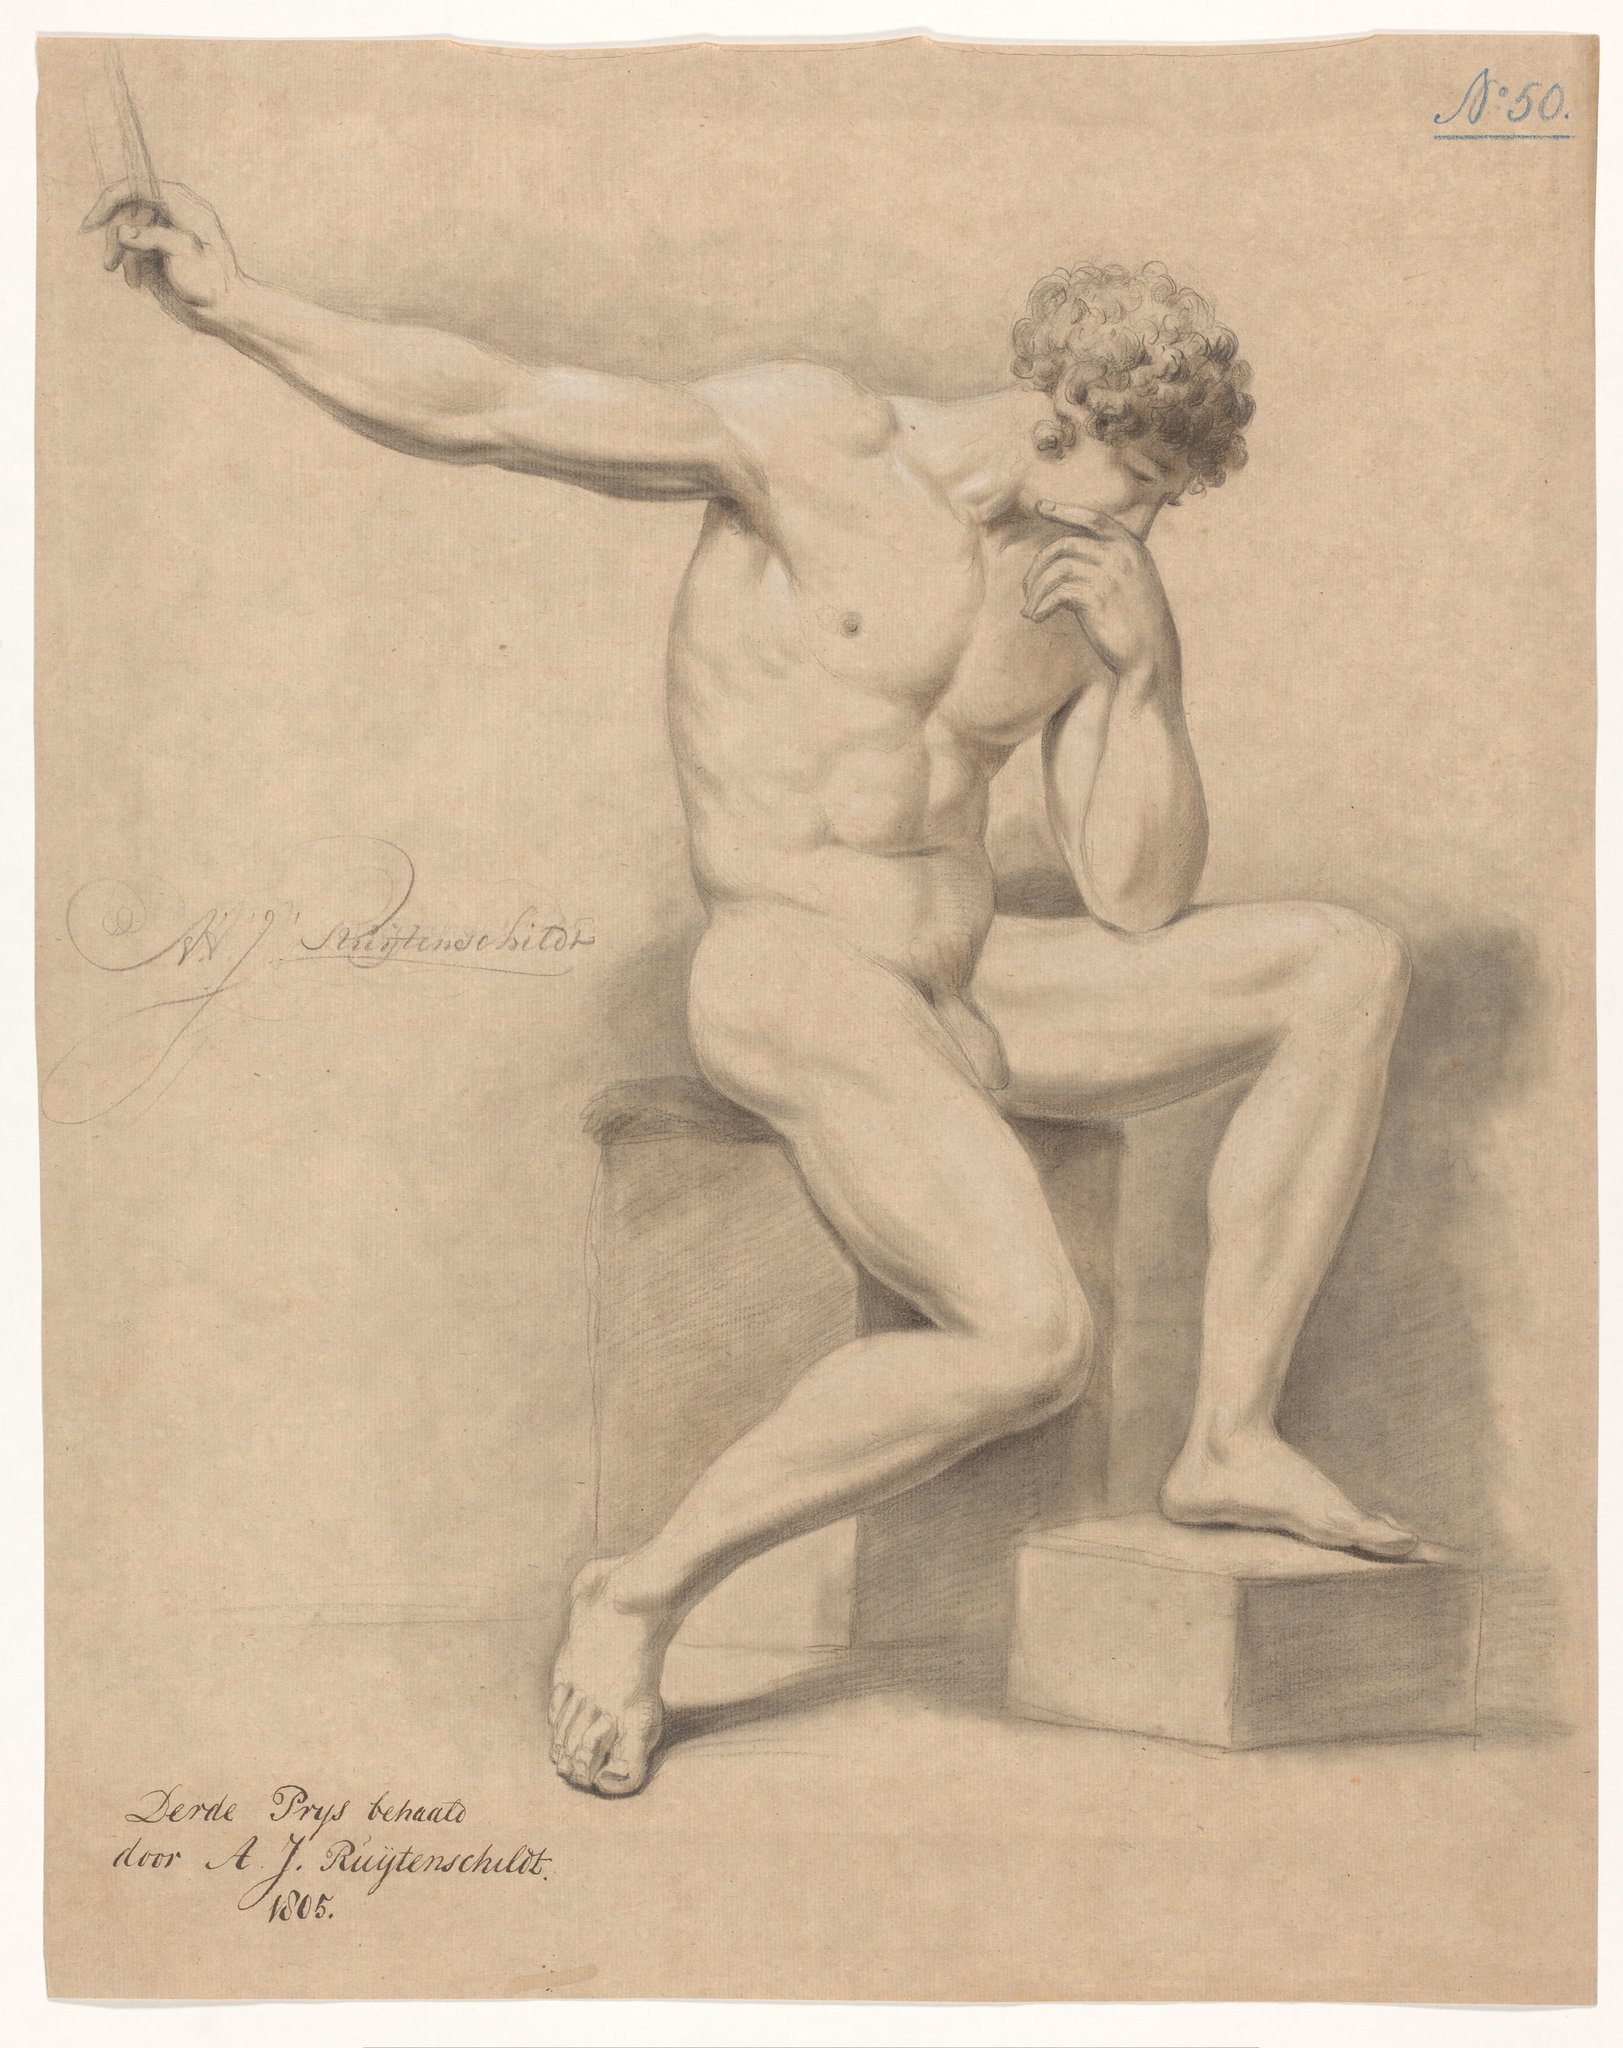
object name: drawing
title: Zittend mannelijk naakt, van voren gezien (3e prijs 1805)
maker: abraham johannes ruytenschildt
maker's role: draughtsman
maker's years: 1778-1841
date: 1805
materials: chalk, paper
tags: sitting figure (+ nude human being)